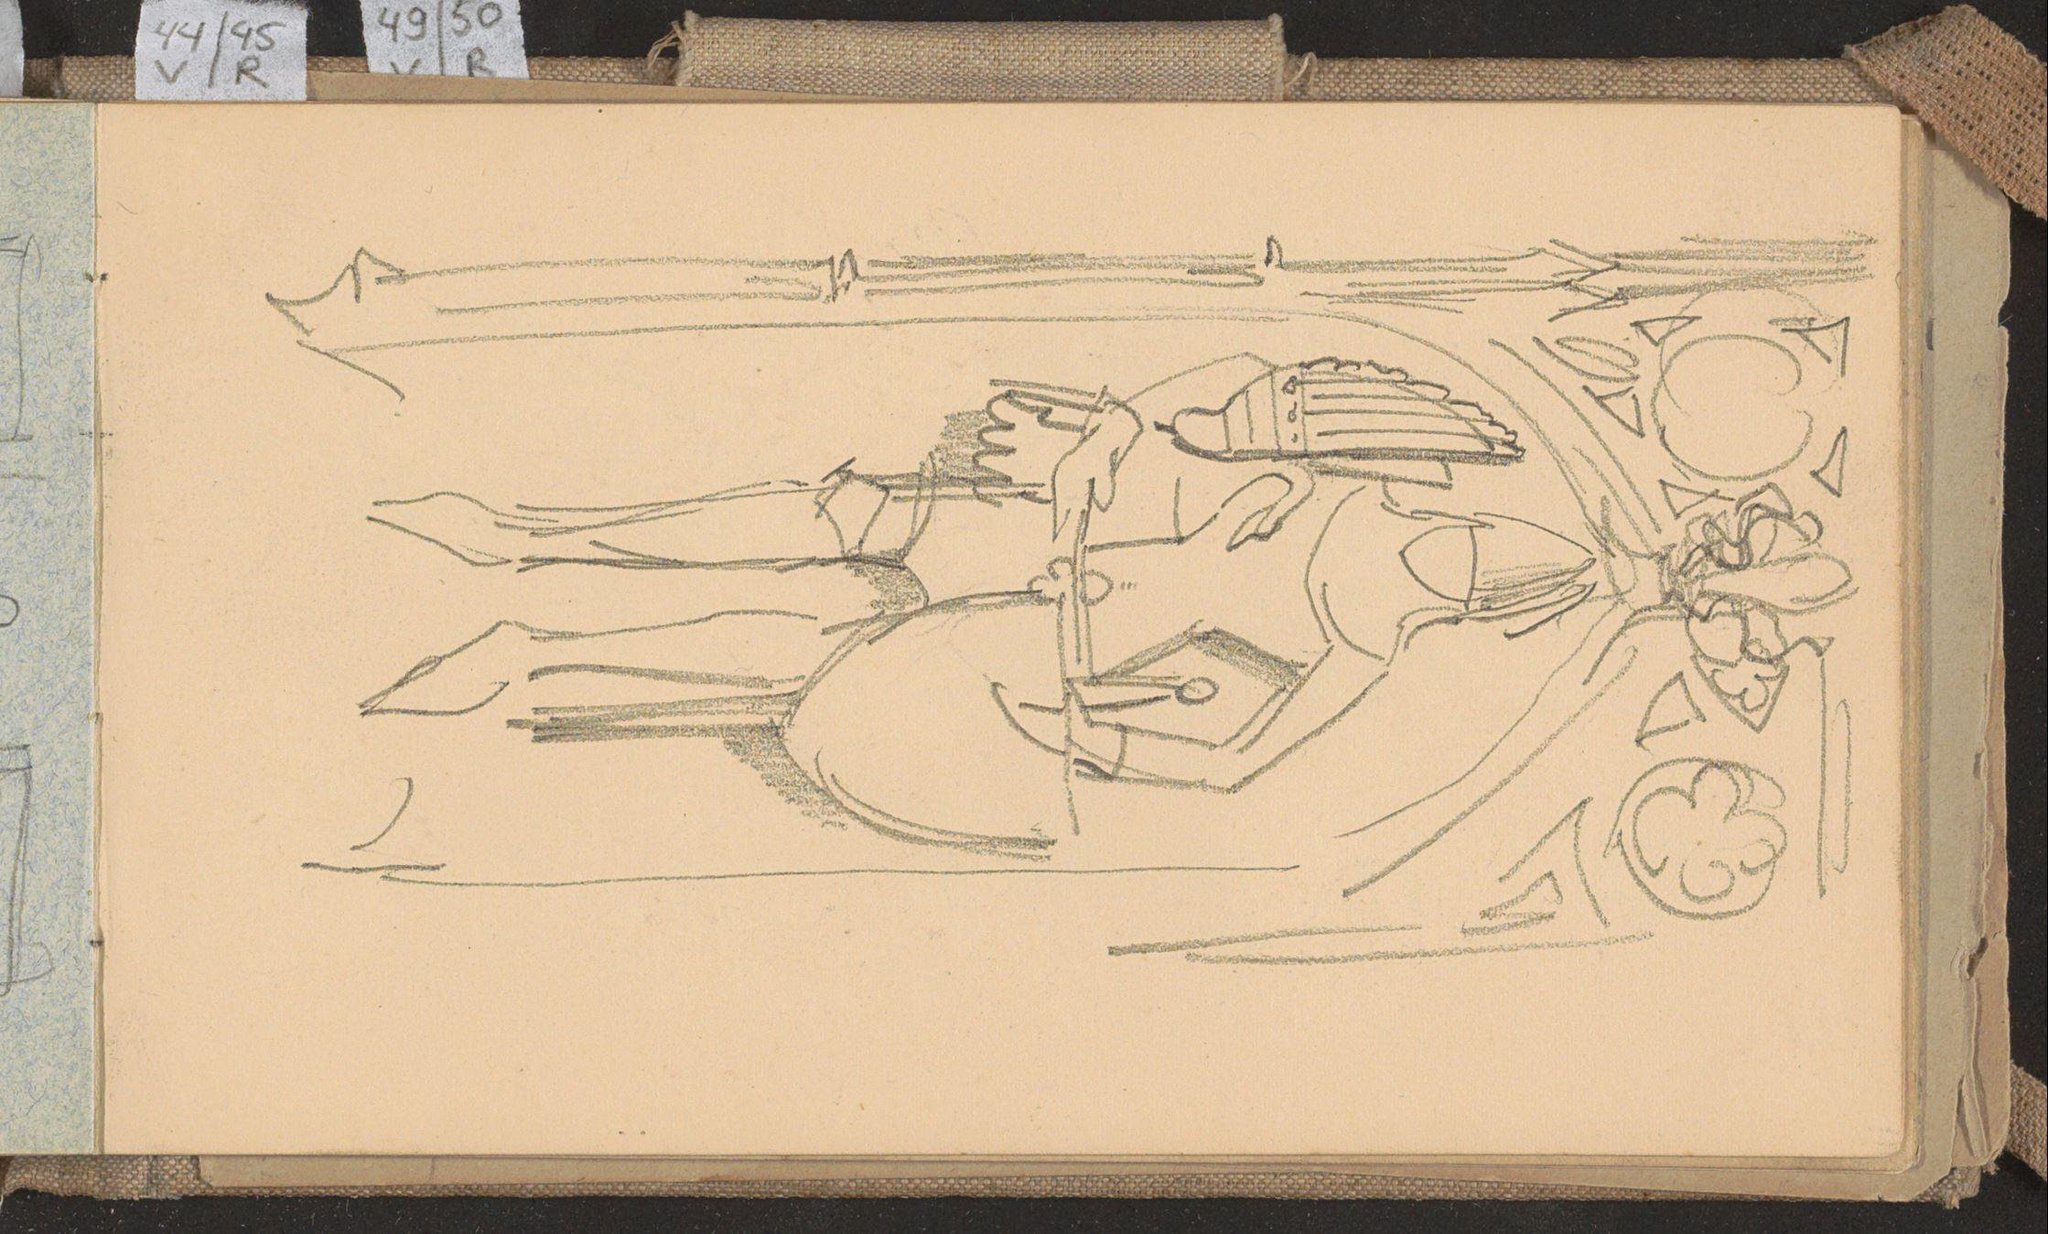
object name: sketchbook leaf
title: Ridder in wapenrusting in een nis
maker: antoon derkinderen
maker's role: draughtsman, painter, print maker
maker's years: 1859-1925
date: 1892-1901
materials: paper, pencil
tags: parts of church interior: niche, knight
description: Blad 40 recto uit een schetsboek met 51 bladen.